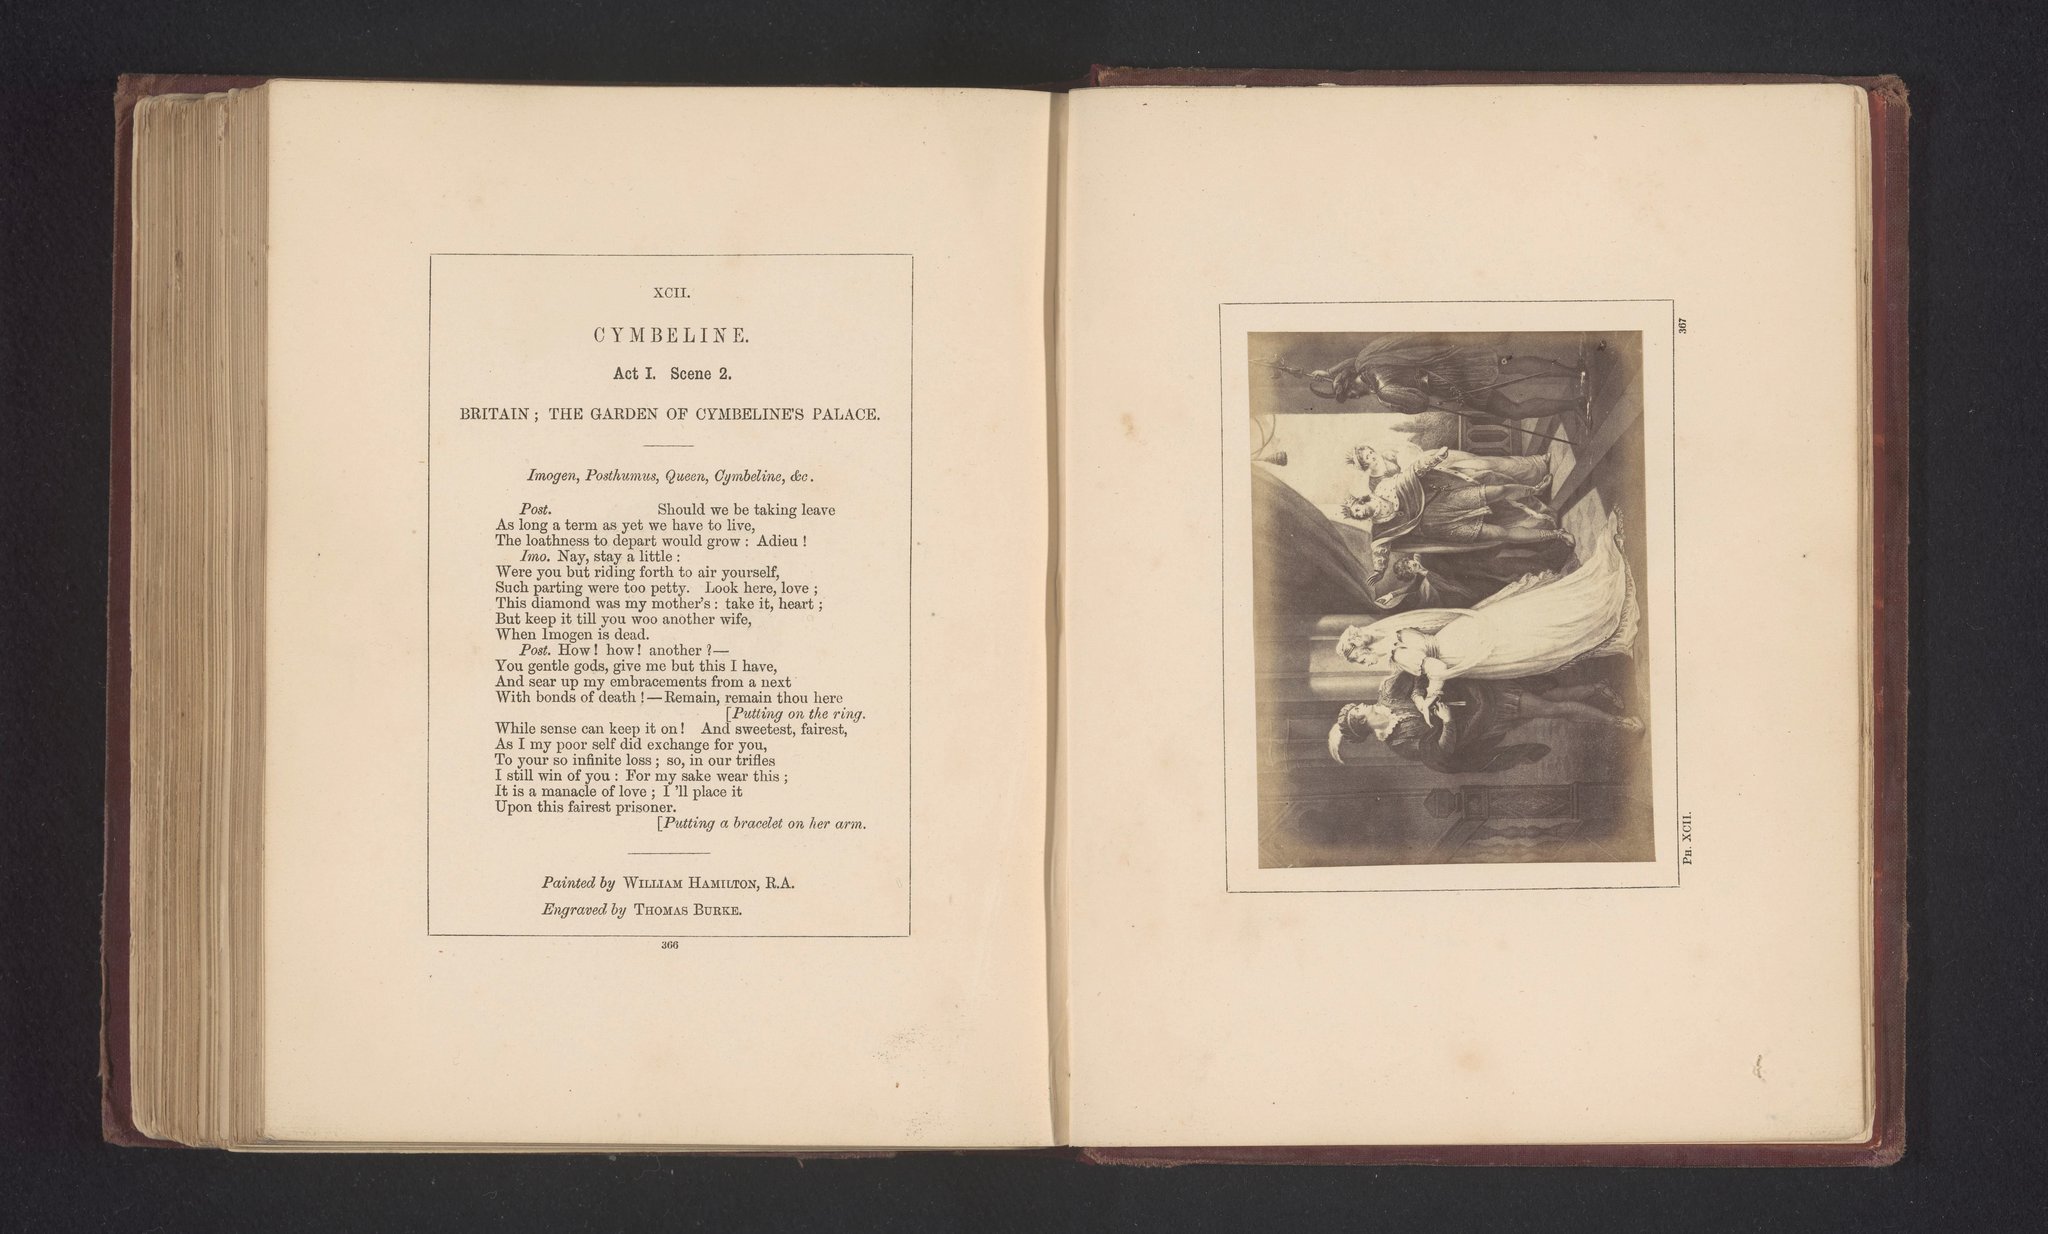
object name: photograph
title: Fotoreproductie van een prent naar een schilderij door William Hamilton, voorstellend een scene uit Cymbeline door William Shakespeare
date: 1854-1867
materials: photographic support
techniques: albumen print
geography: london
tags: (scenes from) specific works of literature: shakespeare, cymbeline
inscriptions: number: ‘Ph. XCII. 367’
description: Te zien is akte I, scene 2 met Imogen en Posthumus die betrapt worden door koning Cymbeline en zijn vrouw.